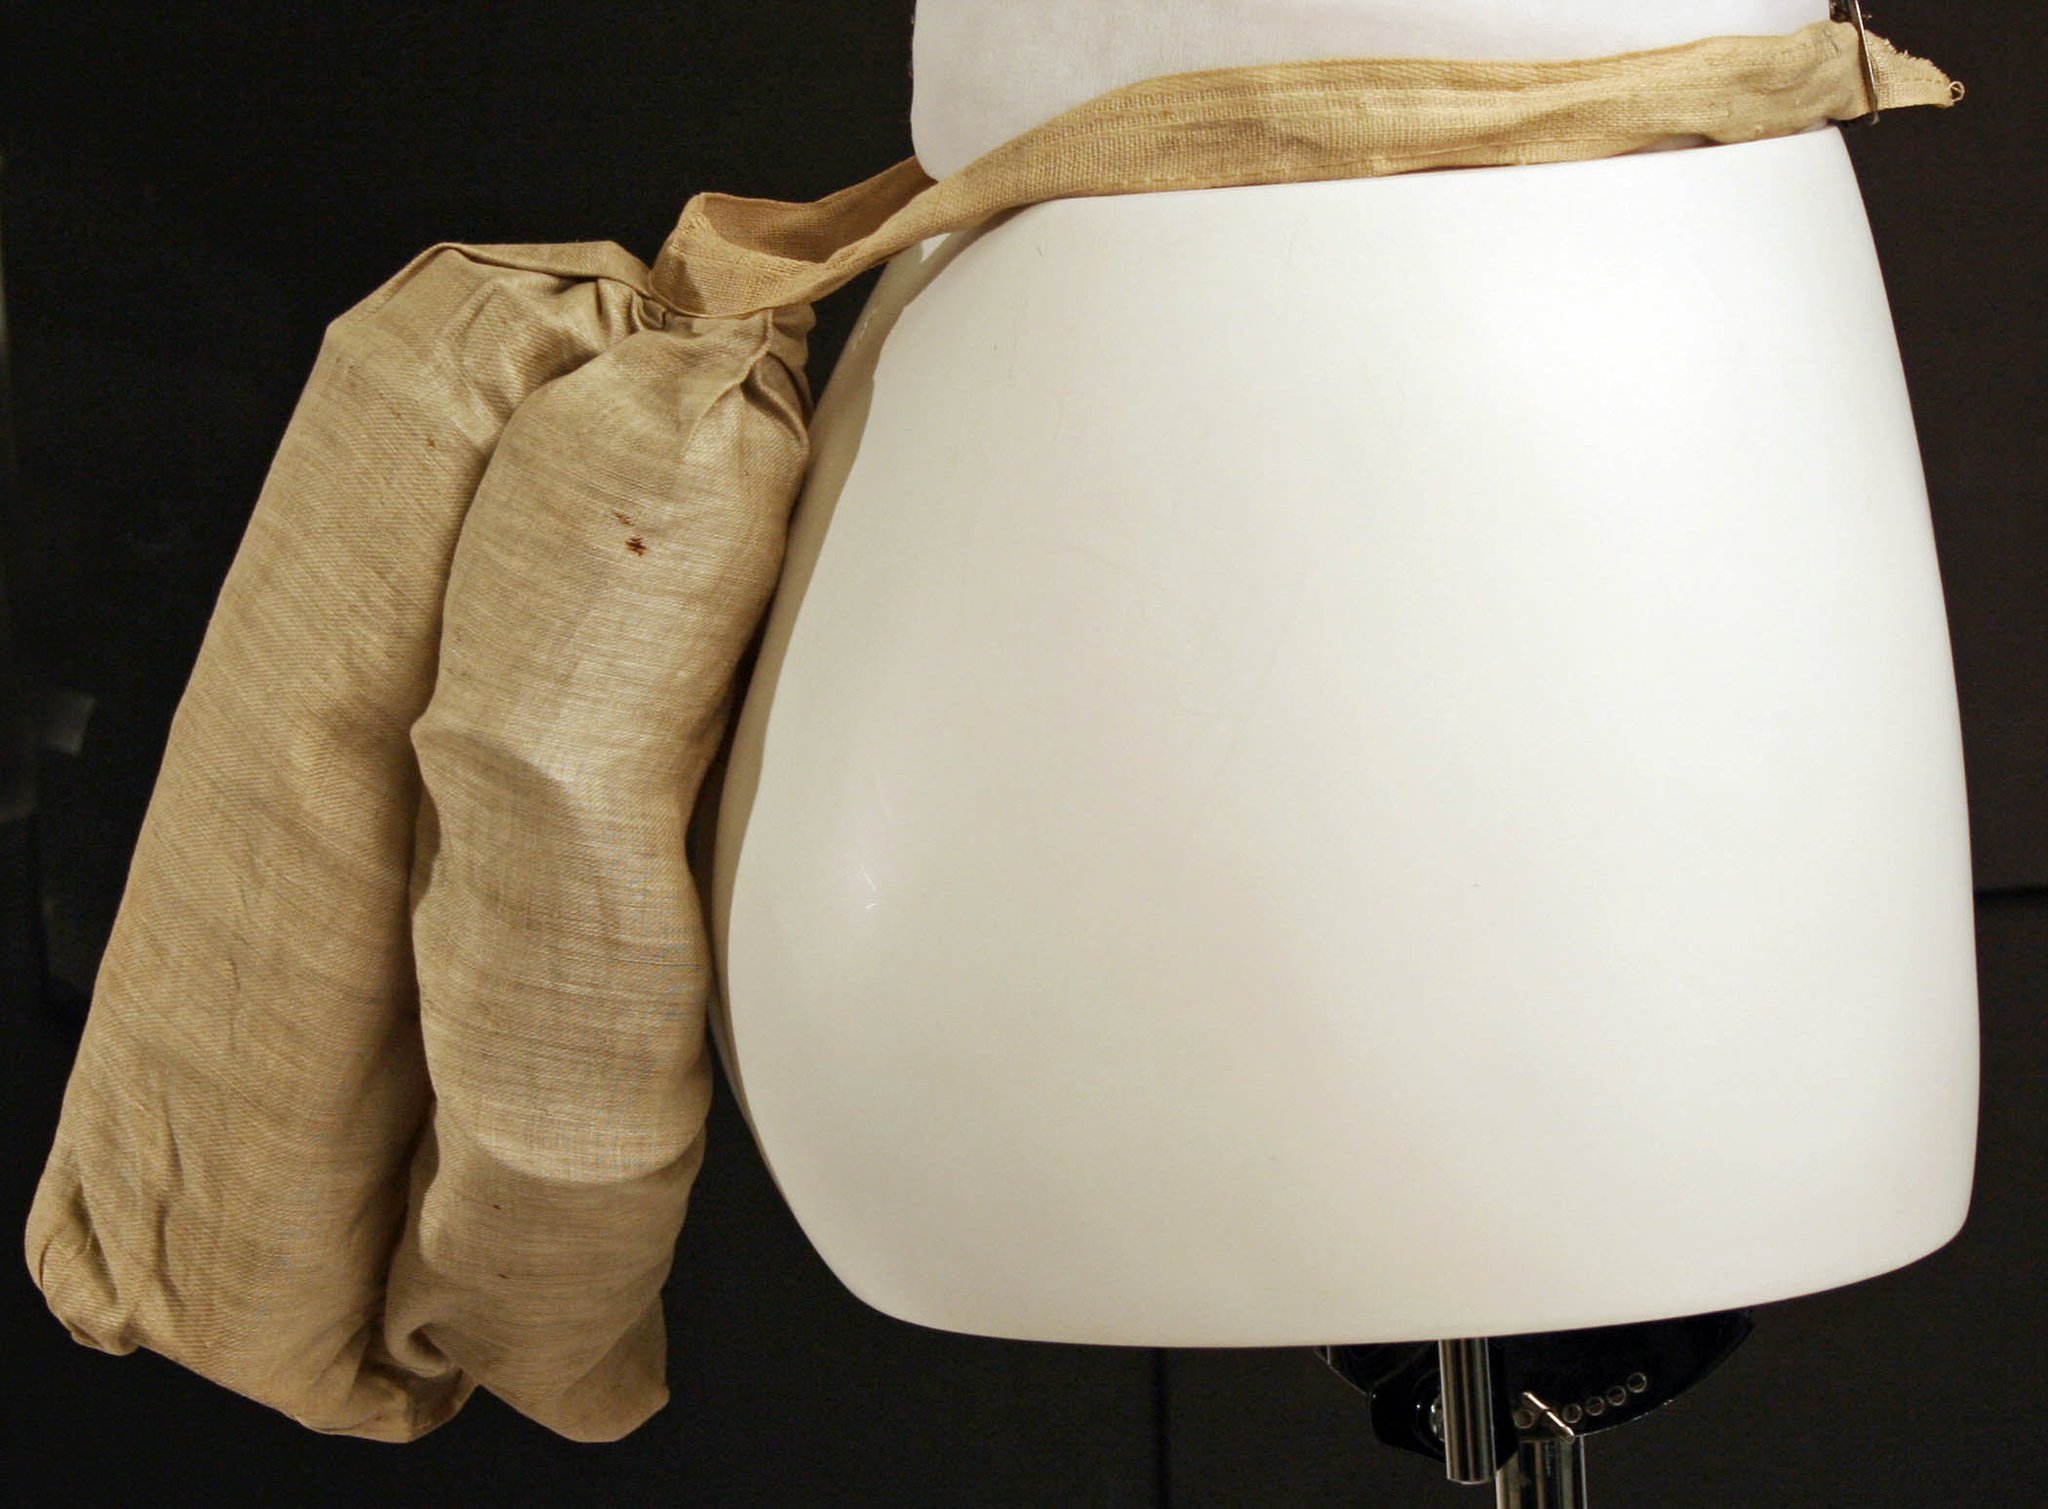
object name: bustle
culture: american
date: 1880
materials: cotton, metal